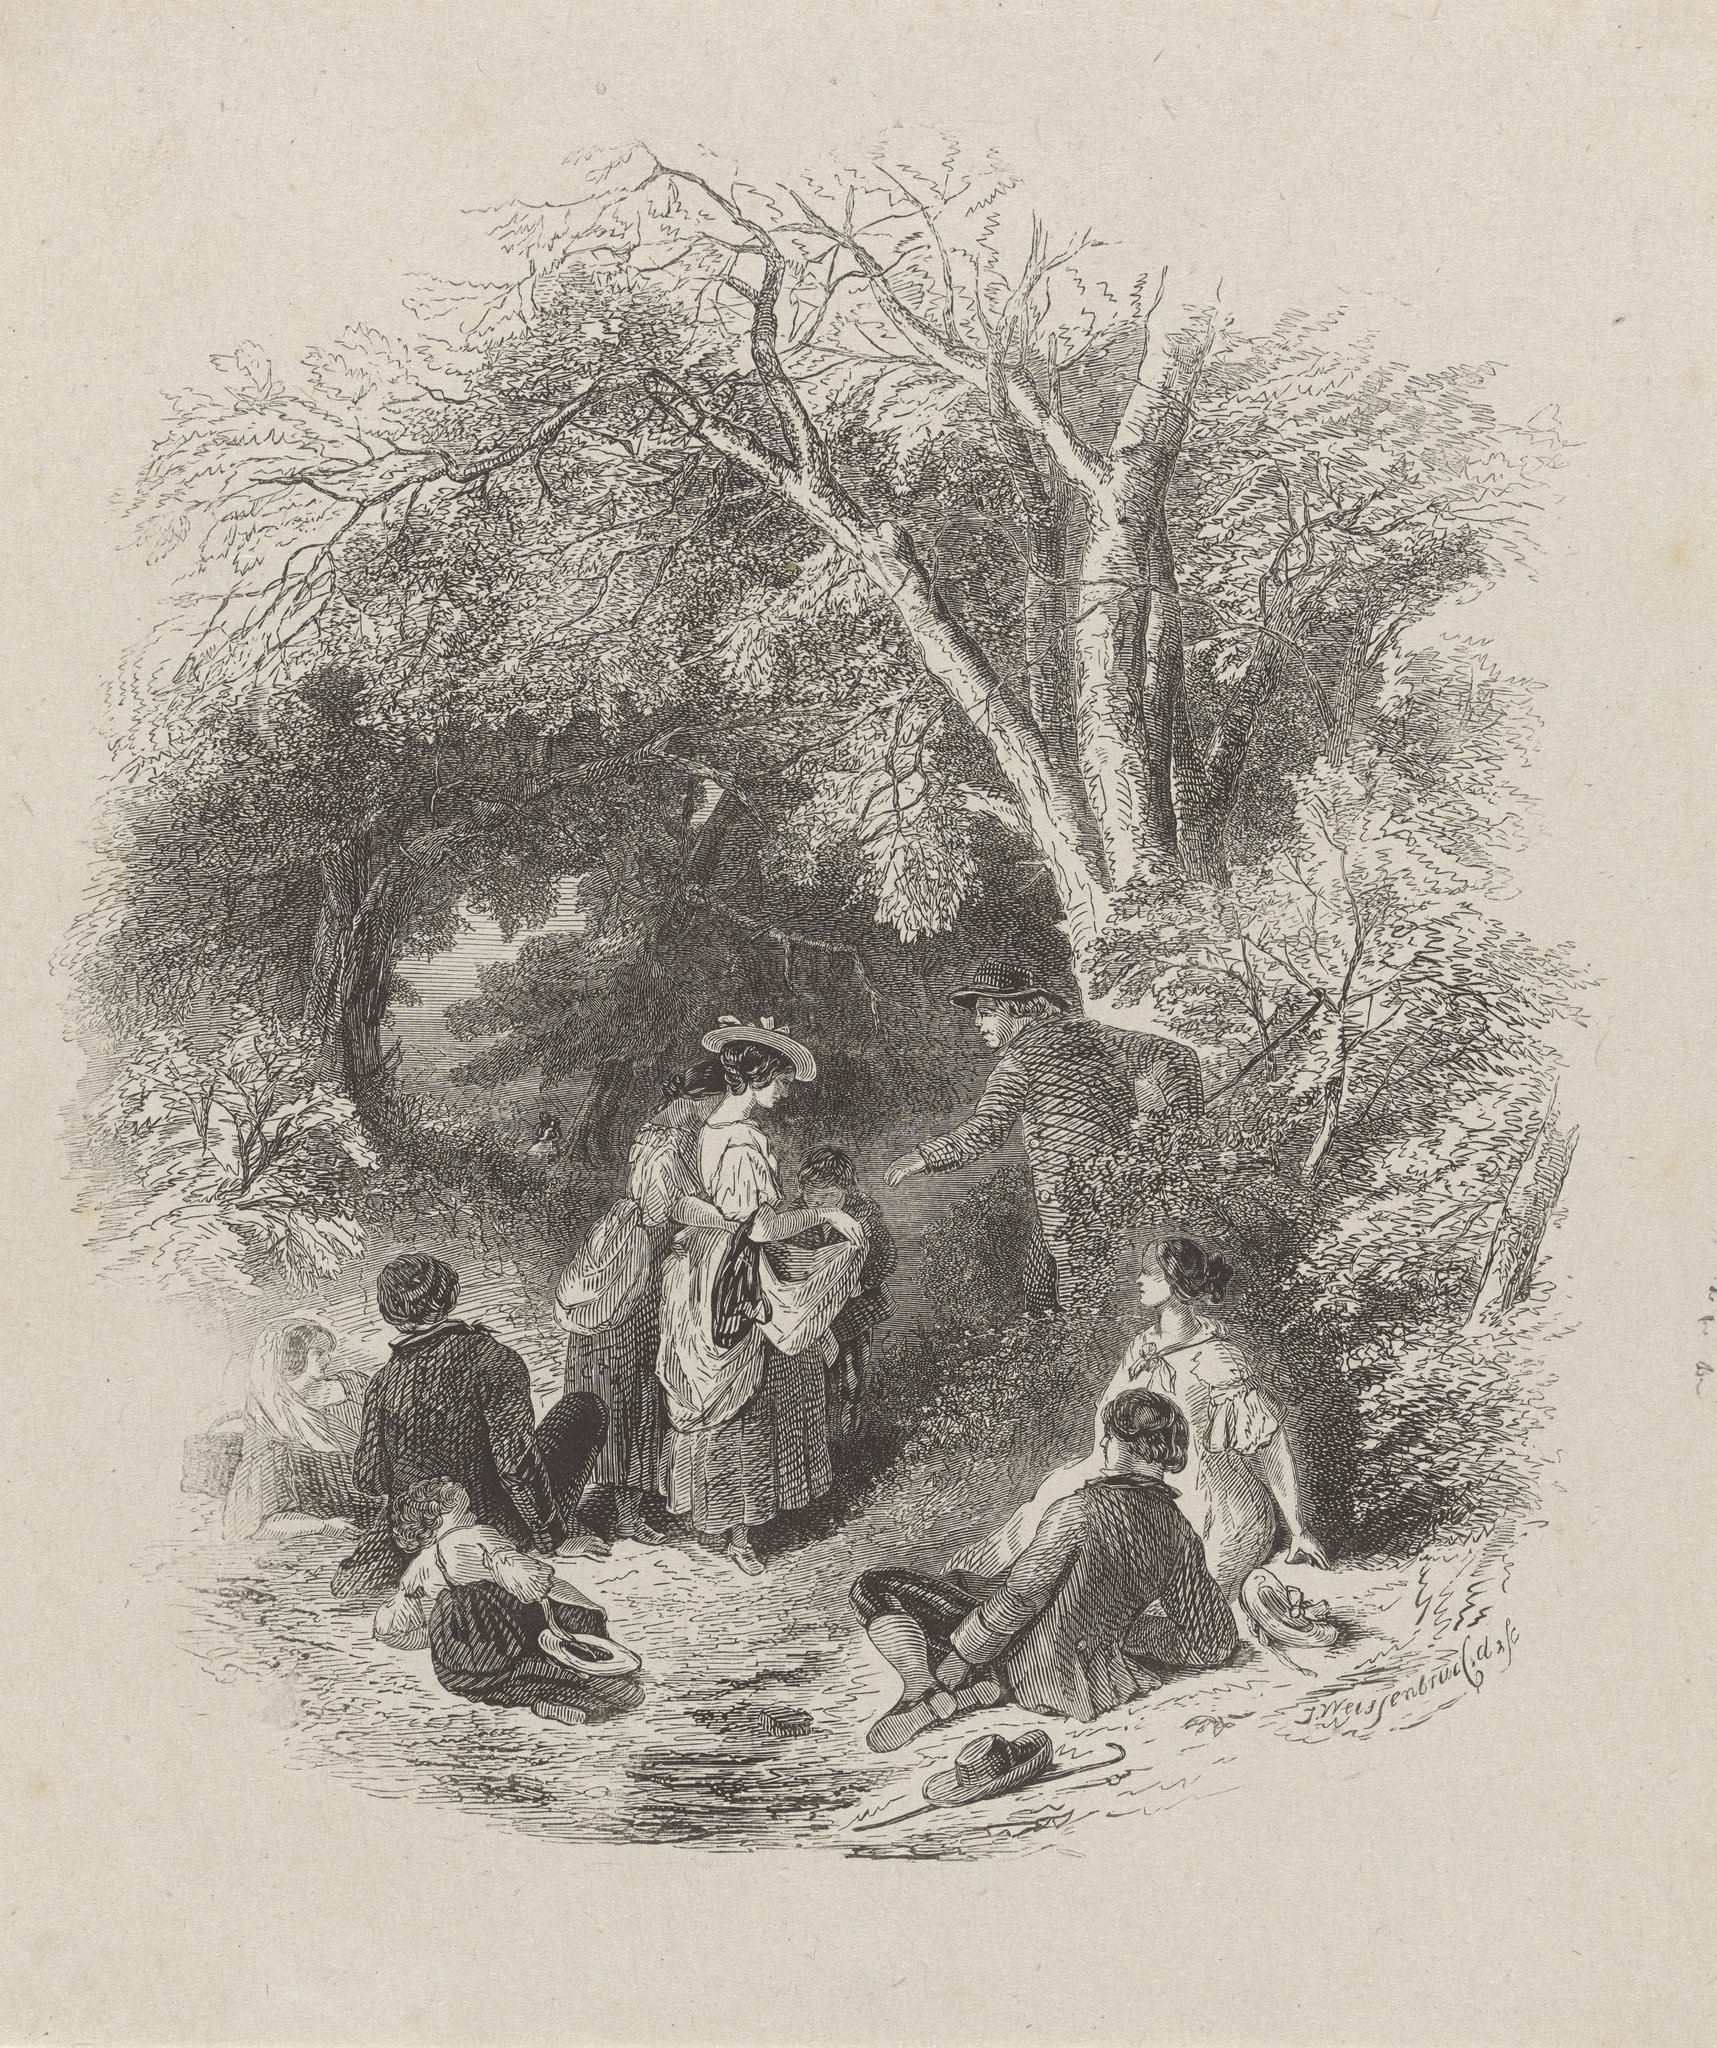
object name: print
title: Gezelschap staand en zittend op de grond in een bos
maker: isaac weissenbruch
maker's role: print maker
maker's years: 1826-1912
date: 1836-1912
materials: paper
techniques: engraving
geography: netherlands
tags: standing figure, forest, wood, sitting on the ground